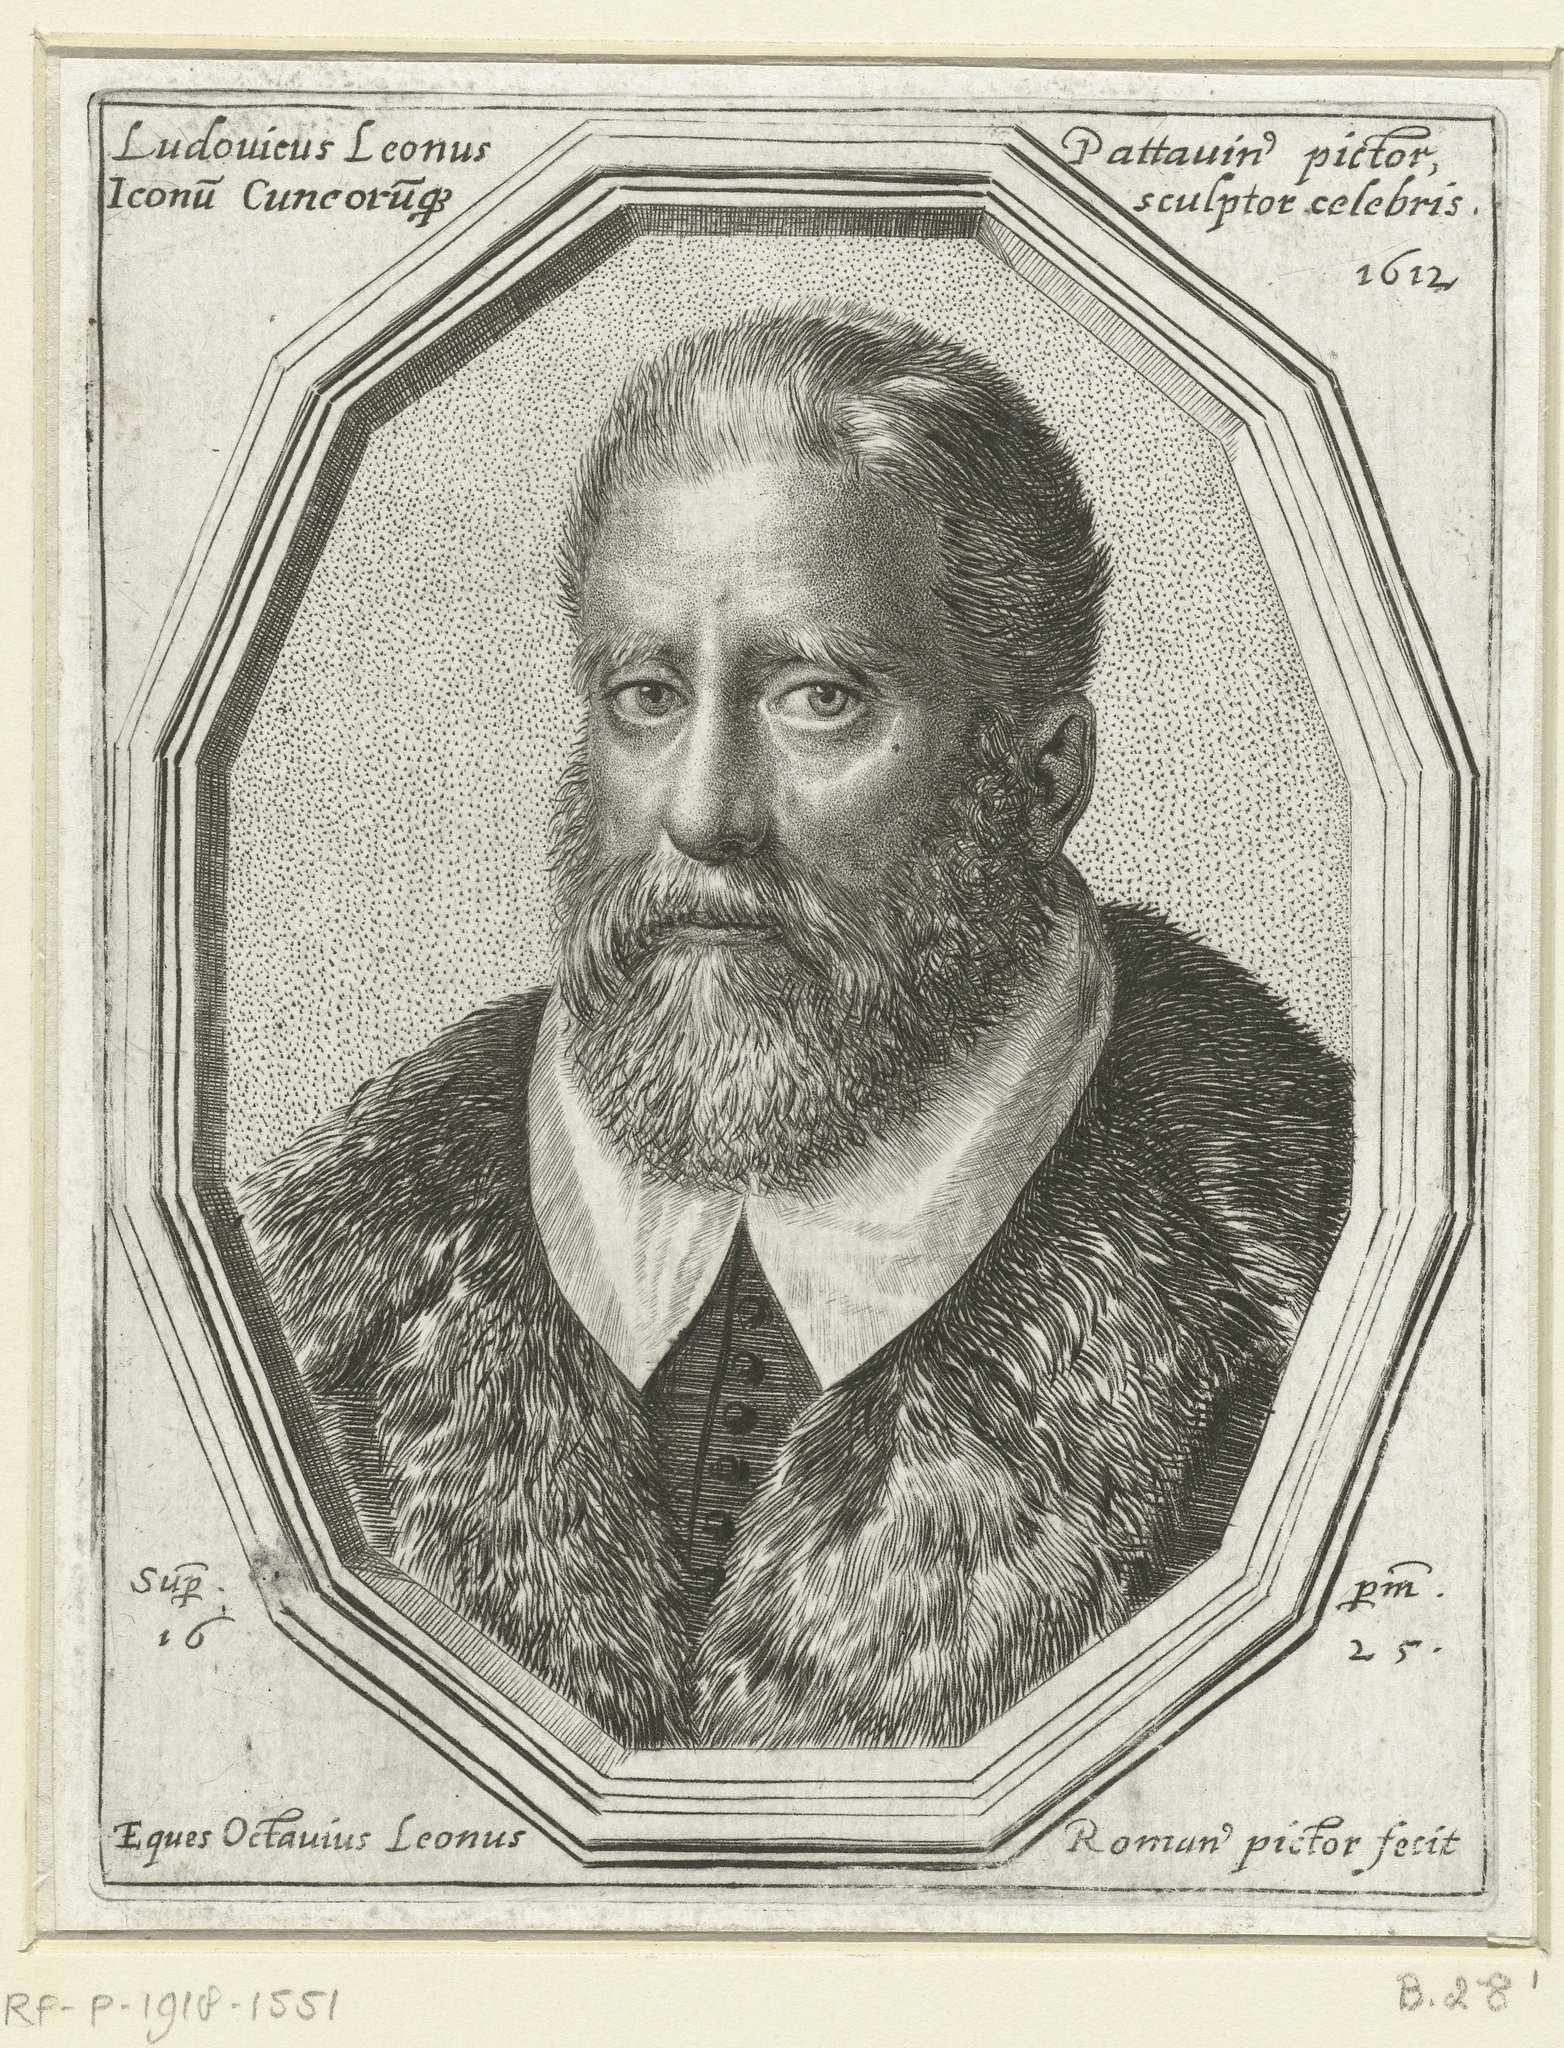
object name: print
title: Portret van Ludovico Leoni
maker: ottavio mario leoni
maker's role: draughtsman, print maker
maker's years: 1578-1630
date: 1625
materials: paper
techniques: etching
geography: italy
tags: rome, ludovico leoni, portrait, self-portrait of artist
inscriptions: collector's mark: Lugt 2233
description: Portret van de kunstenaar Ludovico Leoni, vader van de vervaardiger van de prent.